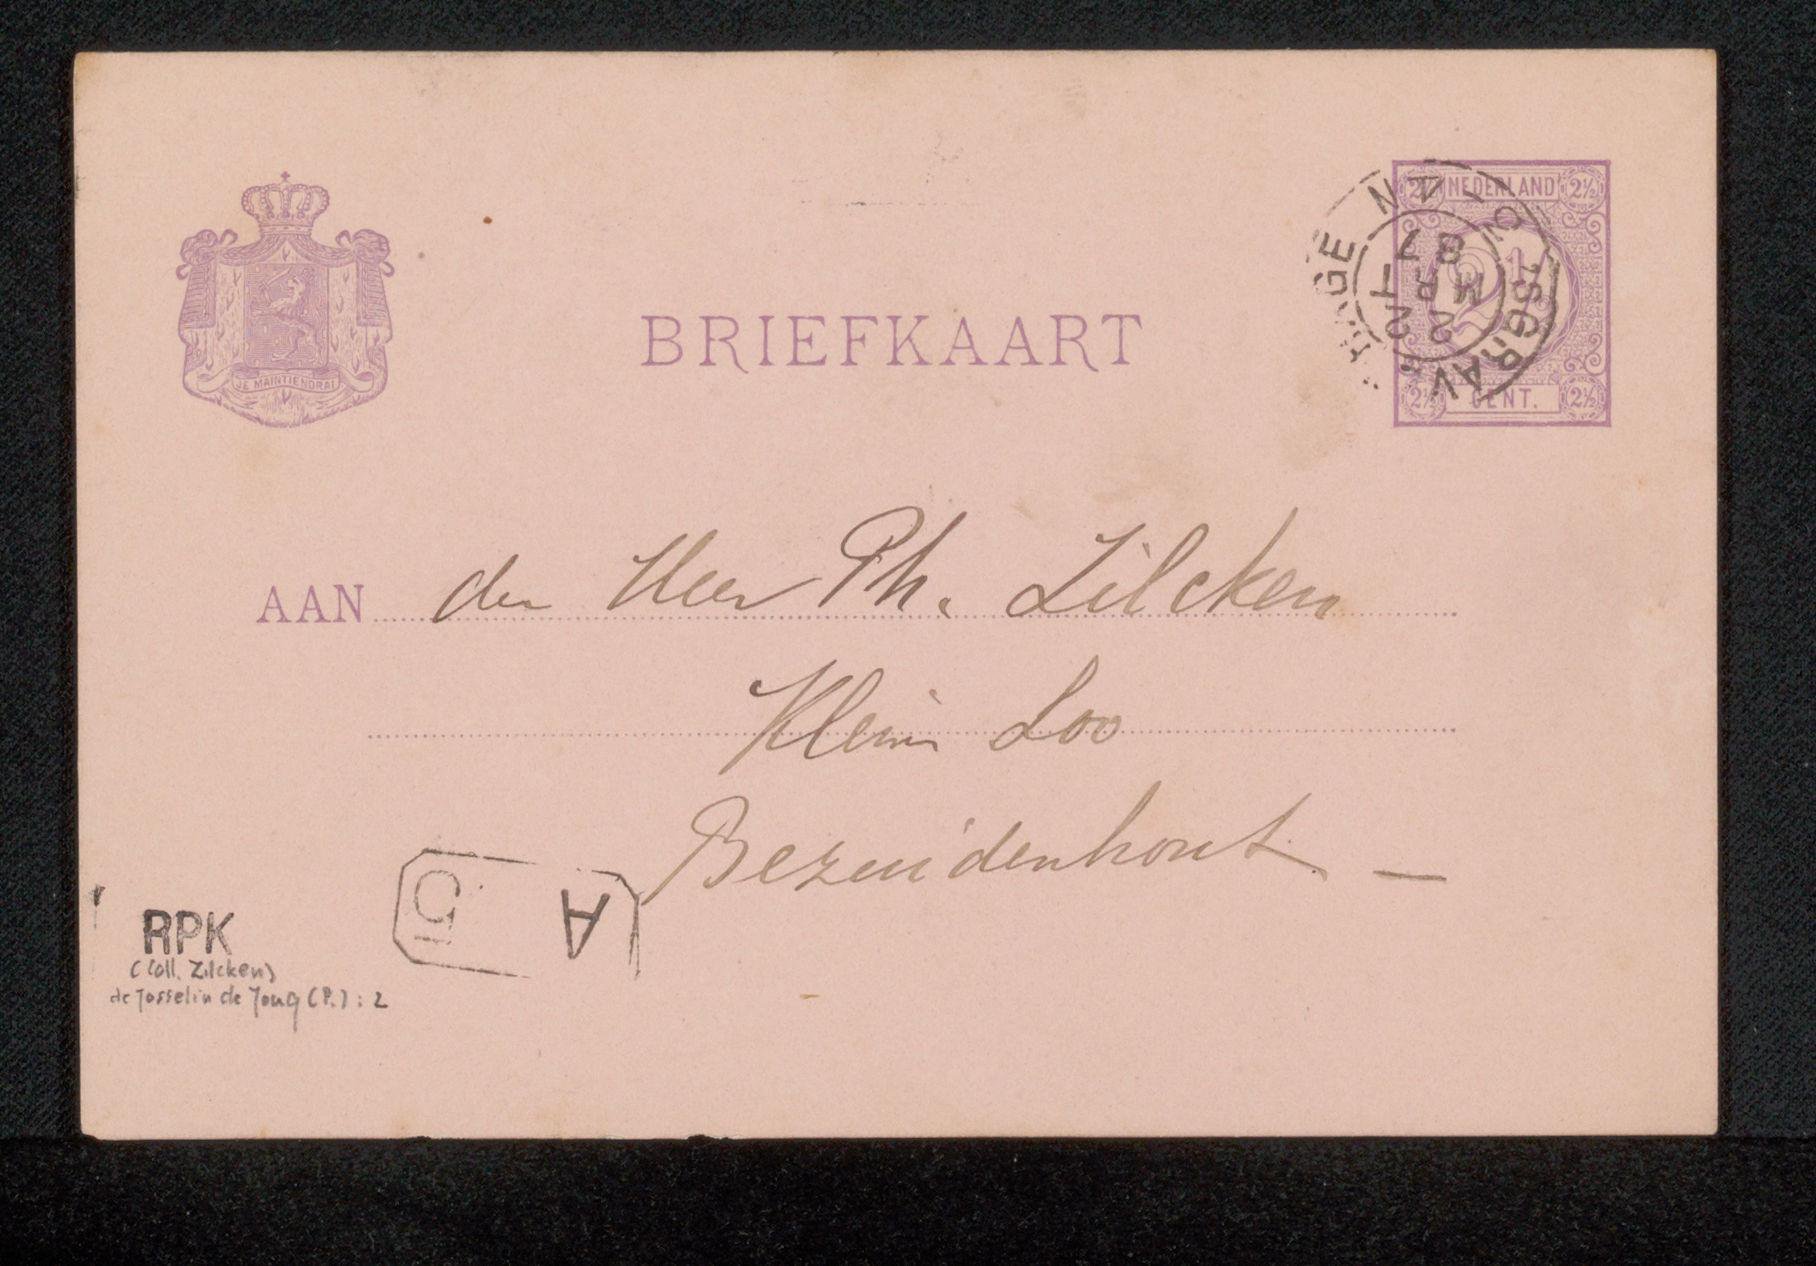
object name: postcard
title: Briefkaart aan Philip Zilcken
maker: pieter de josselin de jong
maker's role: draughtsman, painter, print maker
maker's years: 1861-1906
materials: cardboard, ink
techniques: writing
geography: the hague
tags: the hague, painter, philip zilcken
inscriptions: collector's mark: ‘RPK’